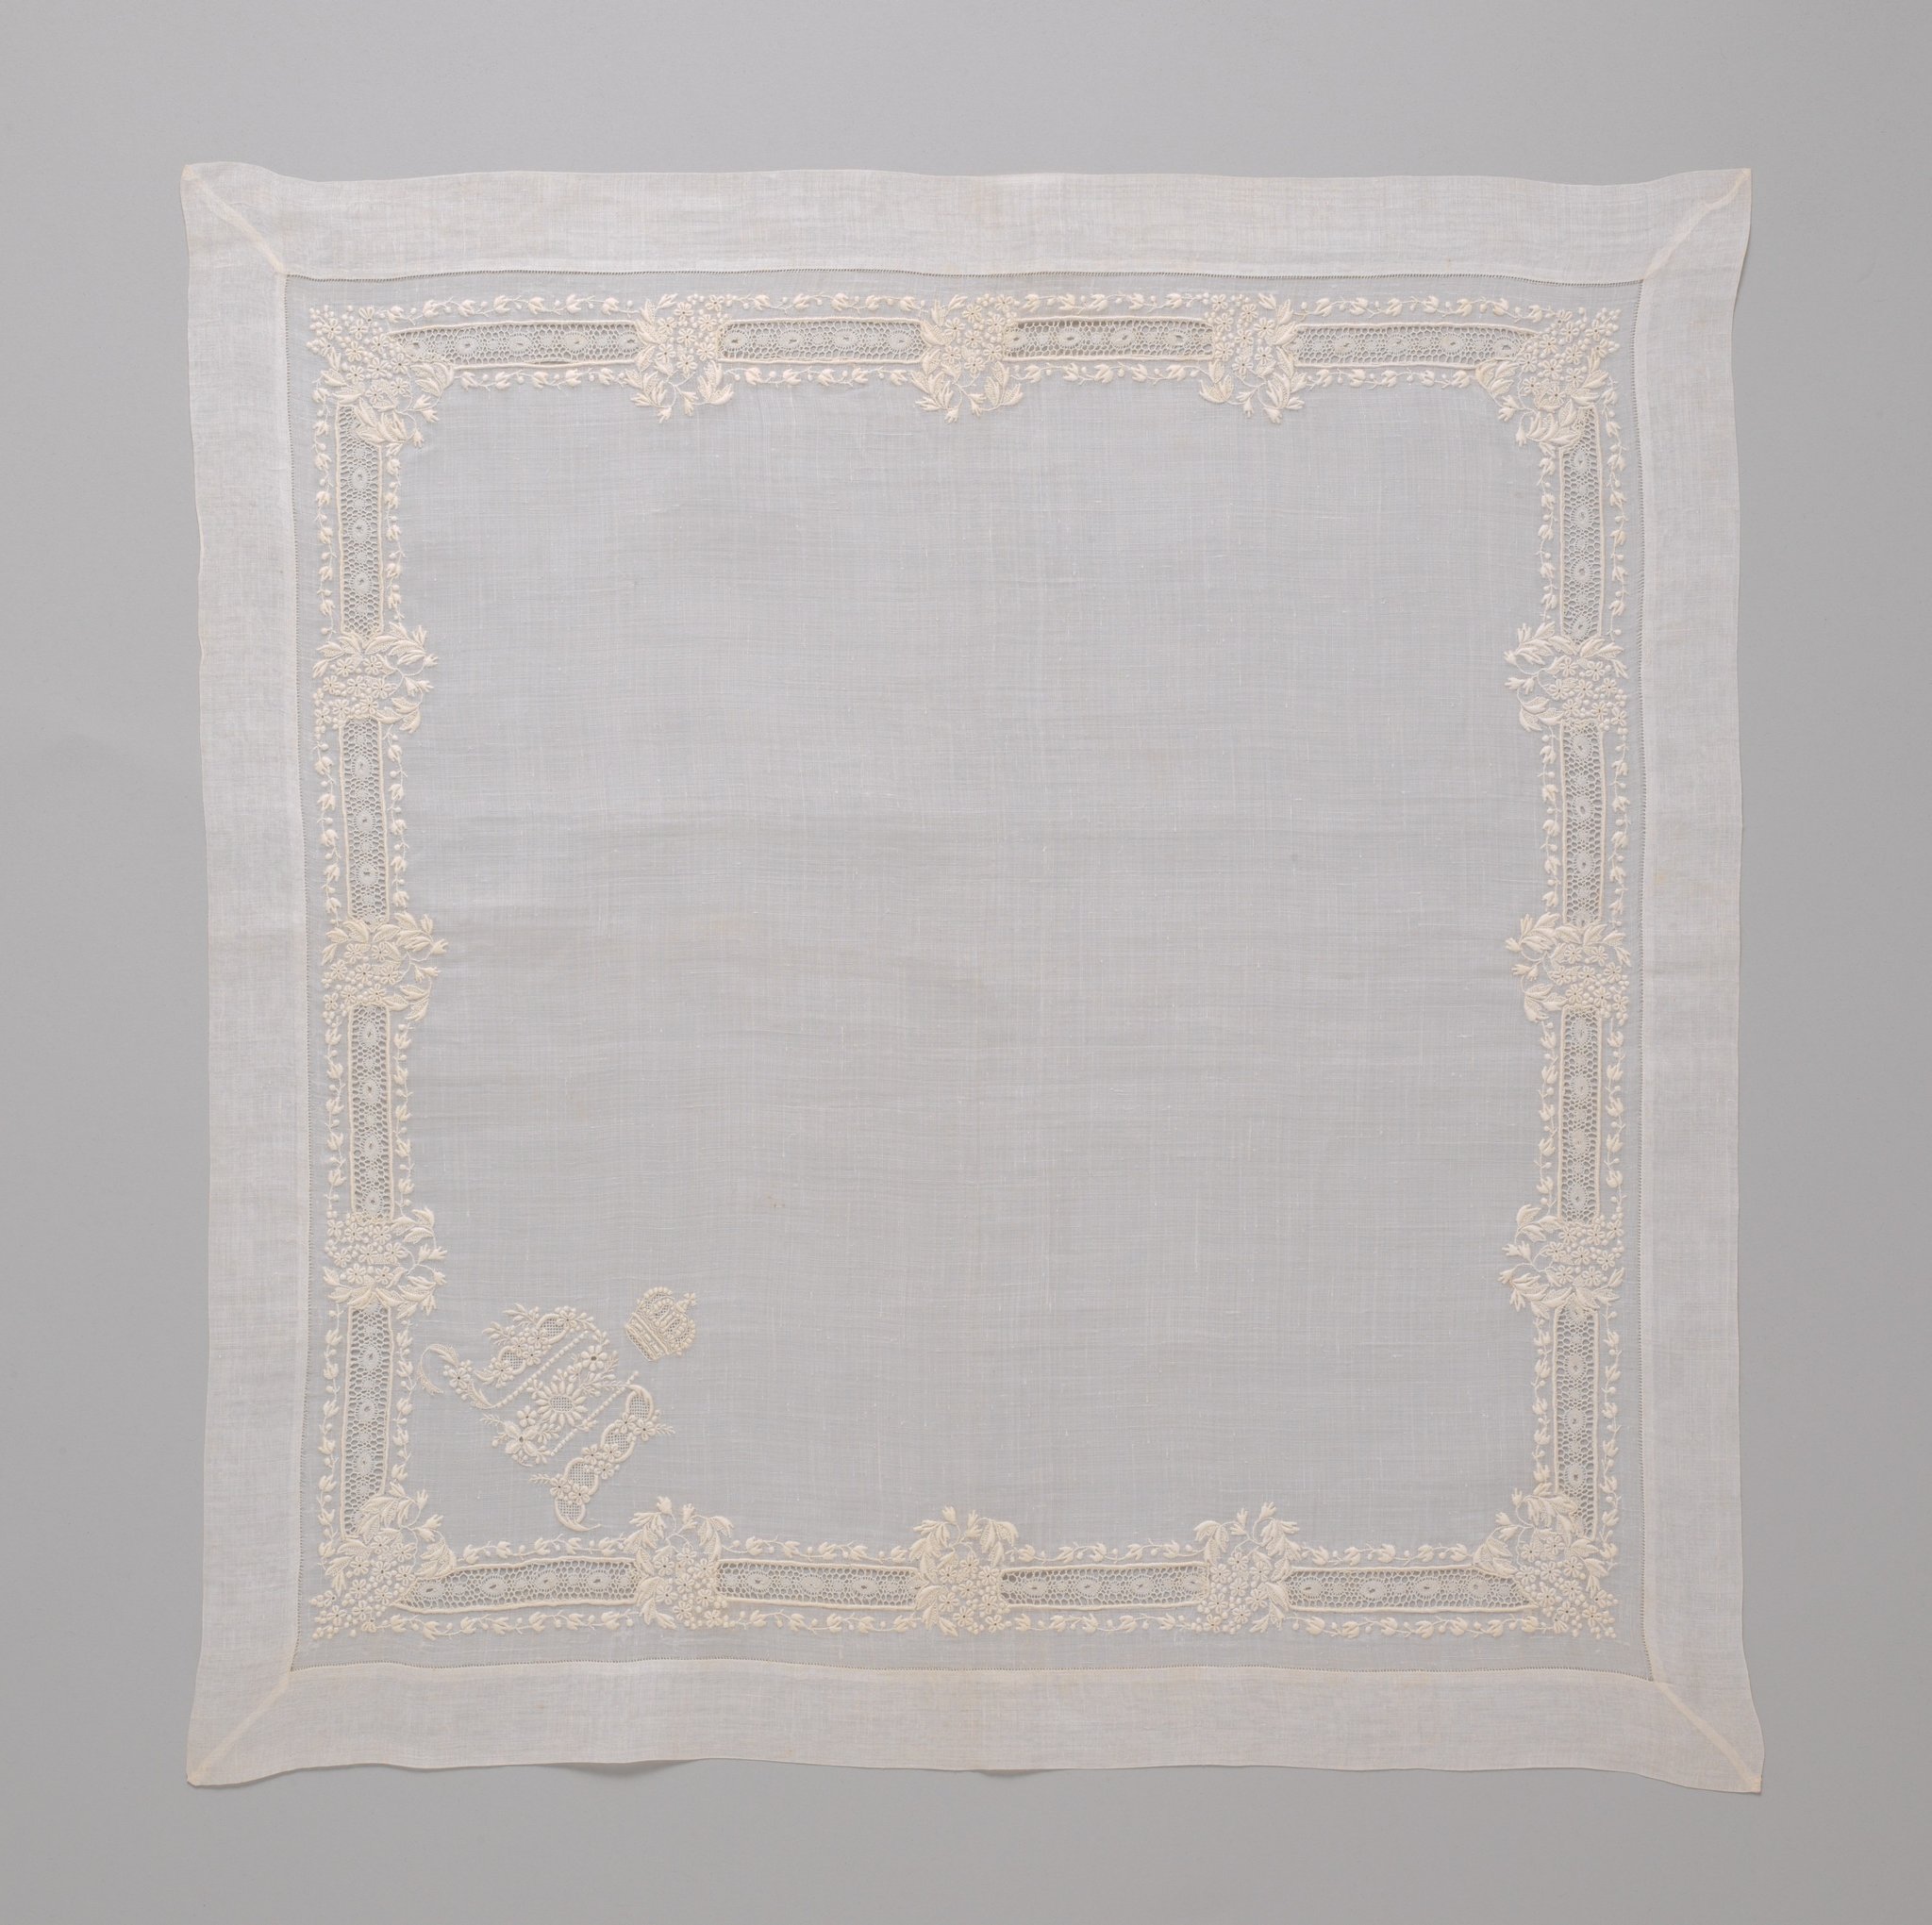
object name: dresser cloth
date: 1840-1880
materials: linen, silk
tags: flowers,insignia